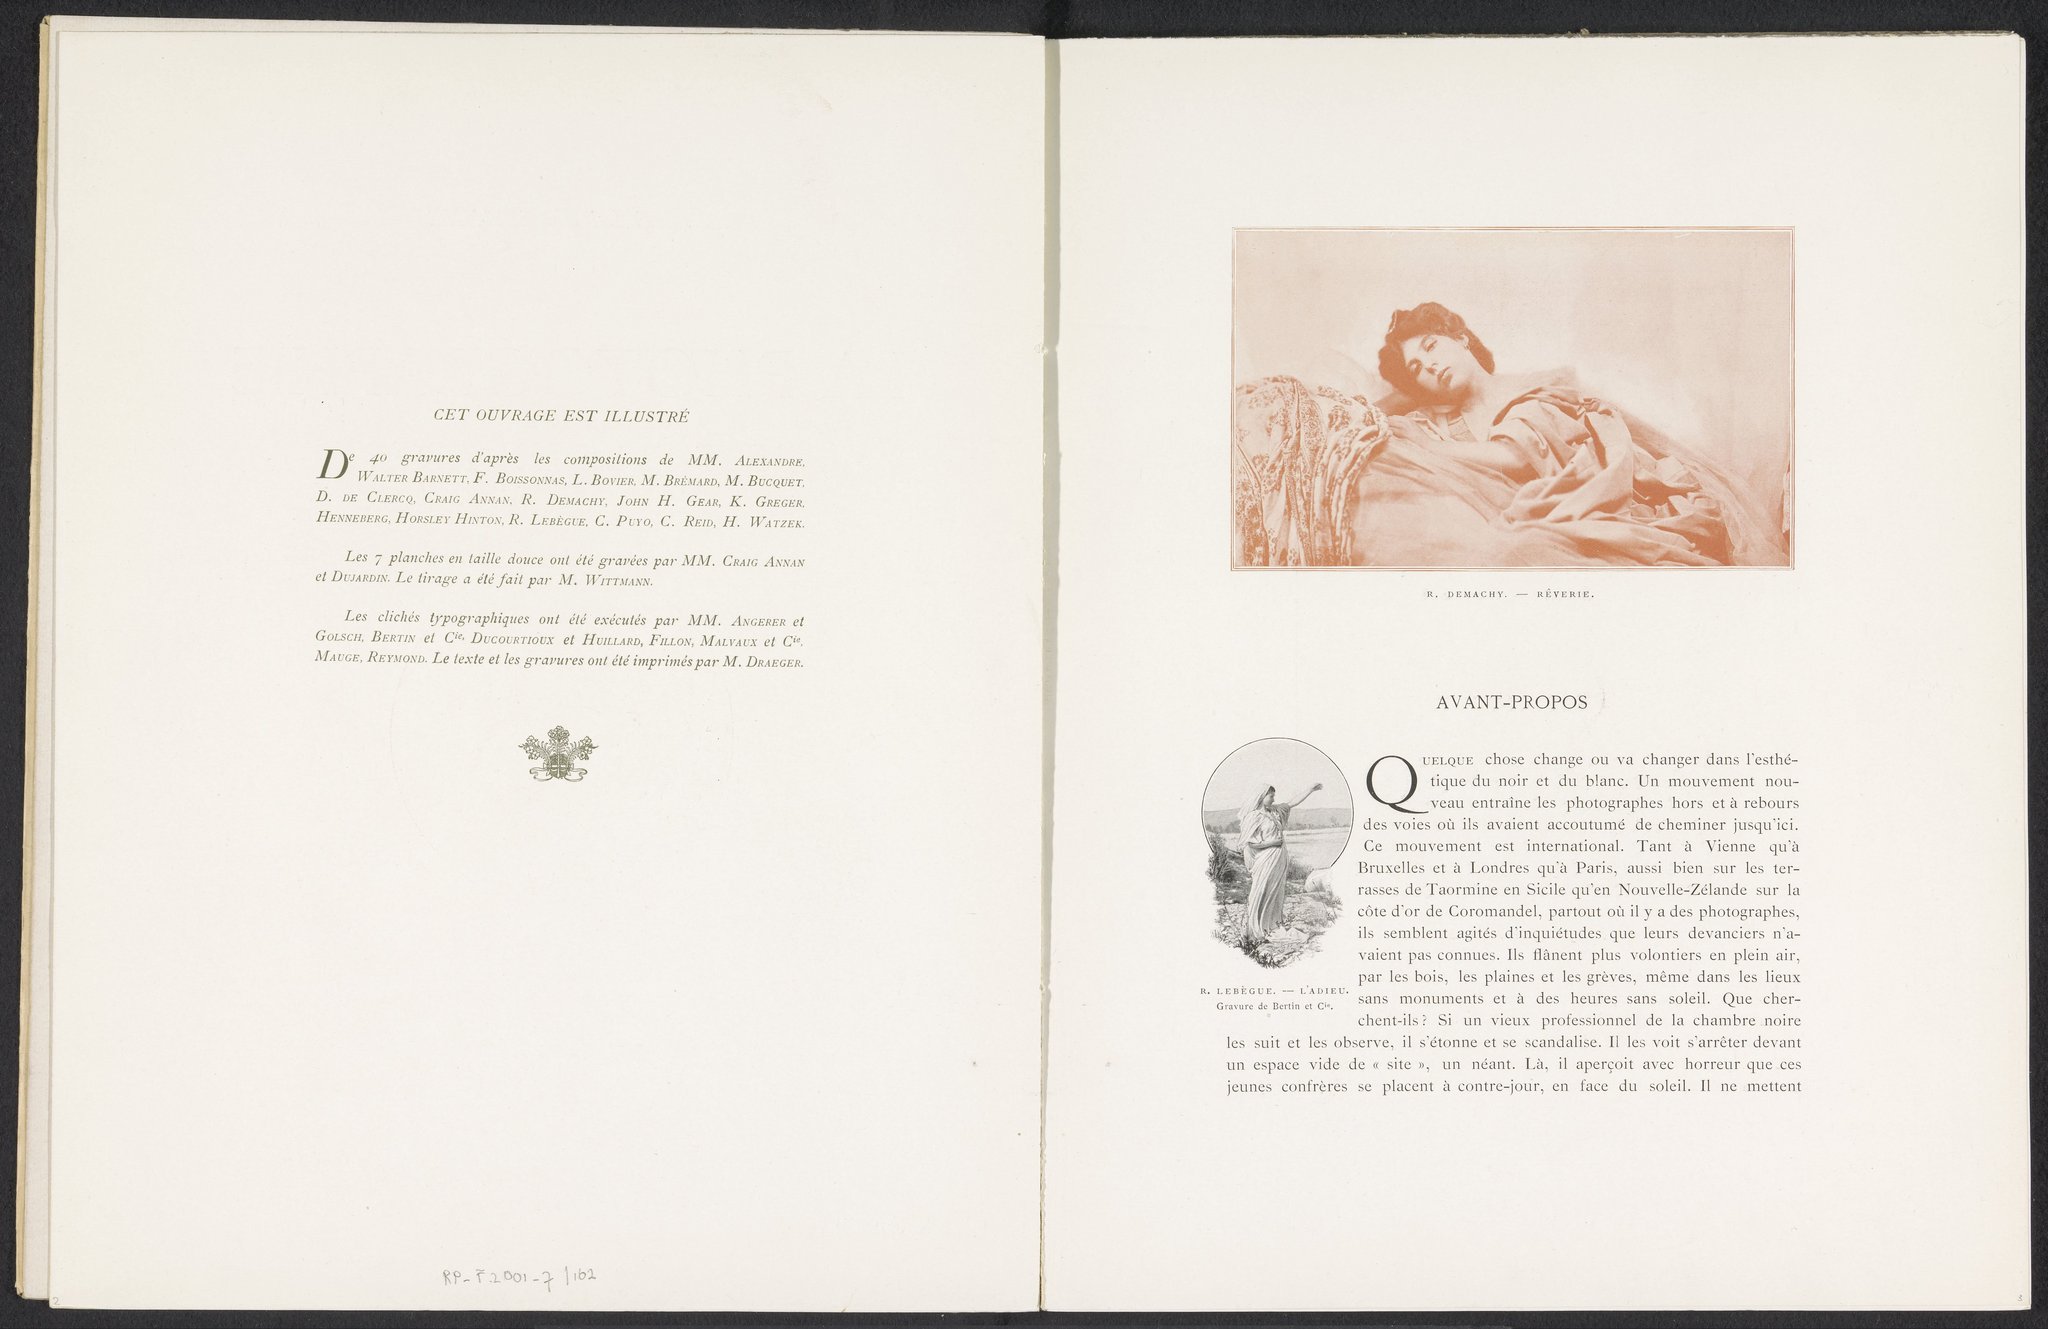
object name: page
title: Rêverie. L'Adieu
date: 1889-1899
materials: paper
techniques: autotype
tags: adult woman, waving farewell ~ departure on a journey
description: Boven: portret van een onbekende, liggende vrouw, onder: vrouw die vaarwel zwaait.